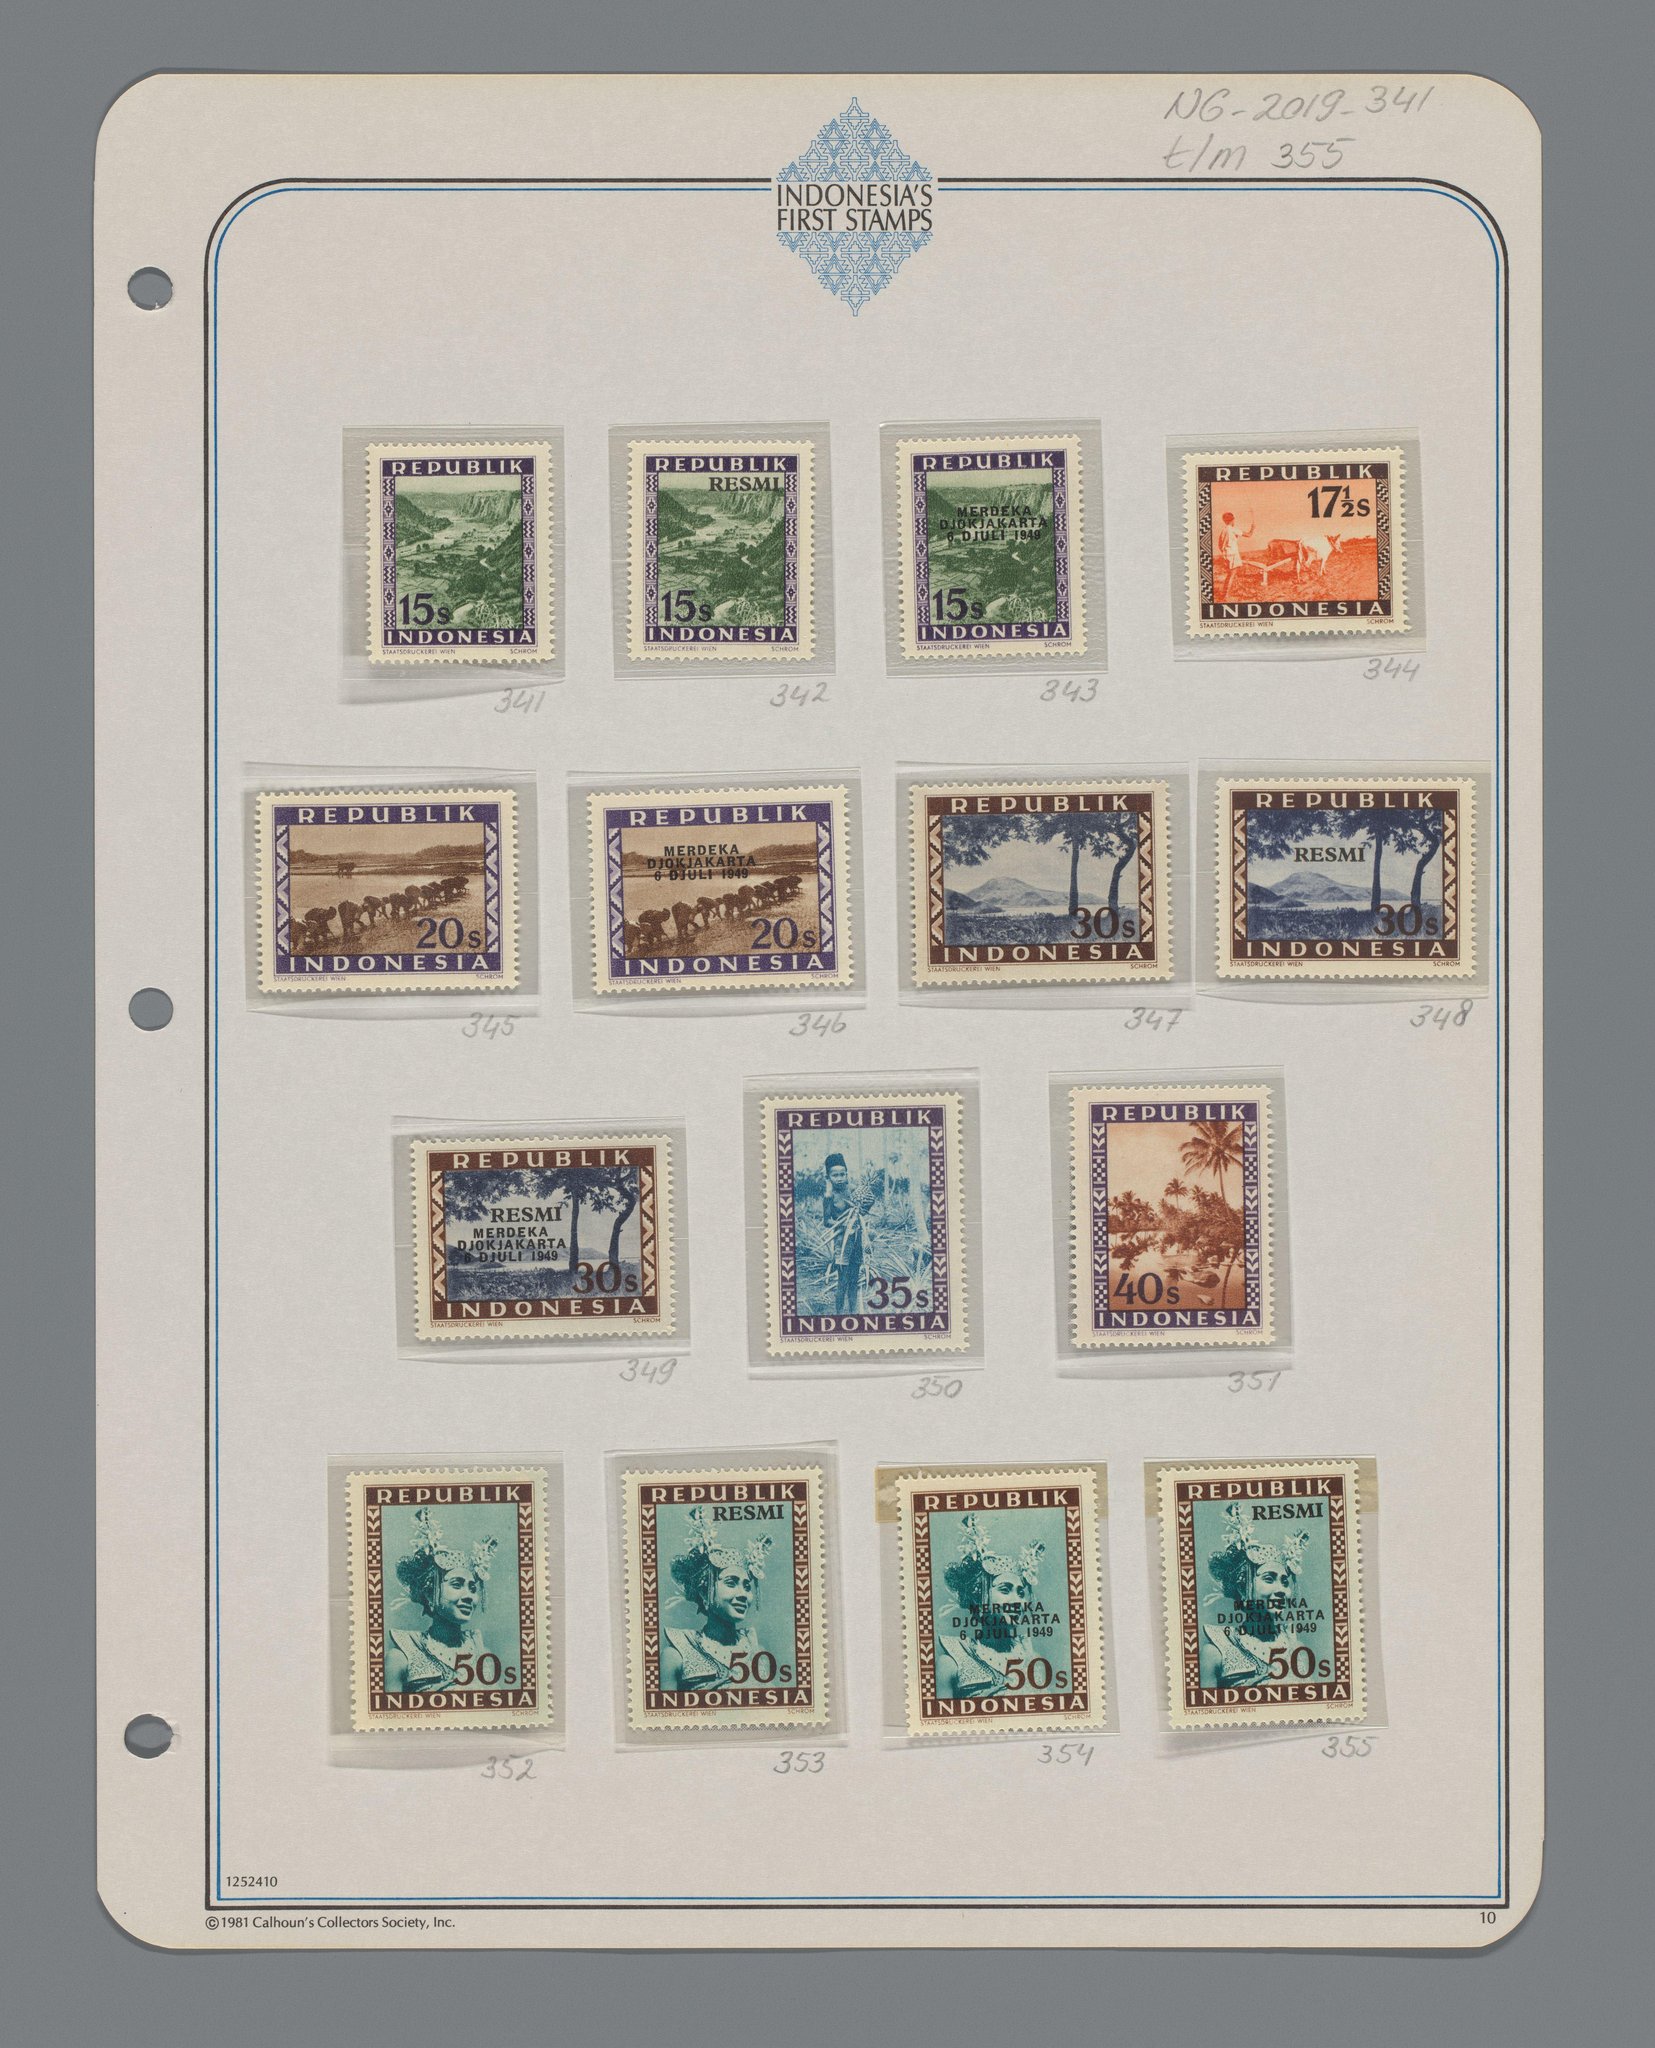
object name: postage stamp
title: Postzegel Republik Indonesia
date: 1949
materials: paper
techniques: photoaquatint, engraving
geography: philadelphia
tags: indonesia